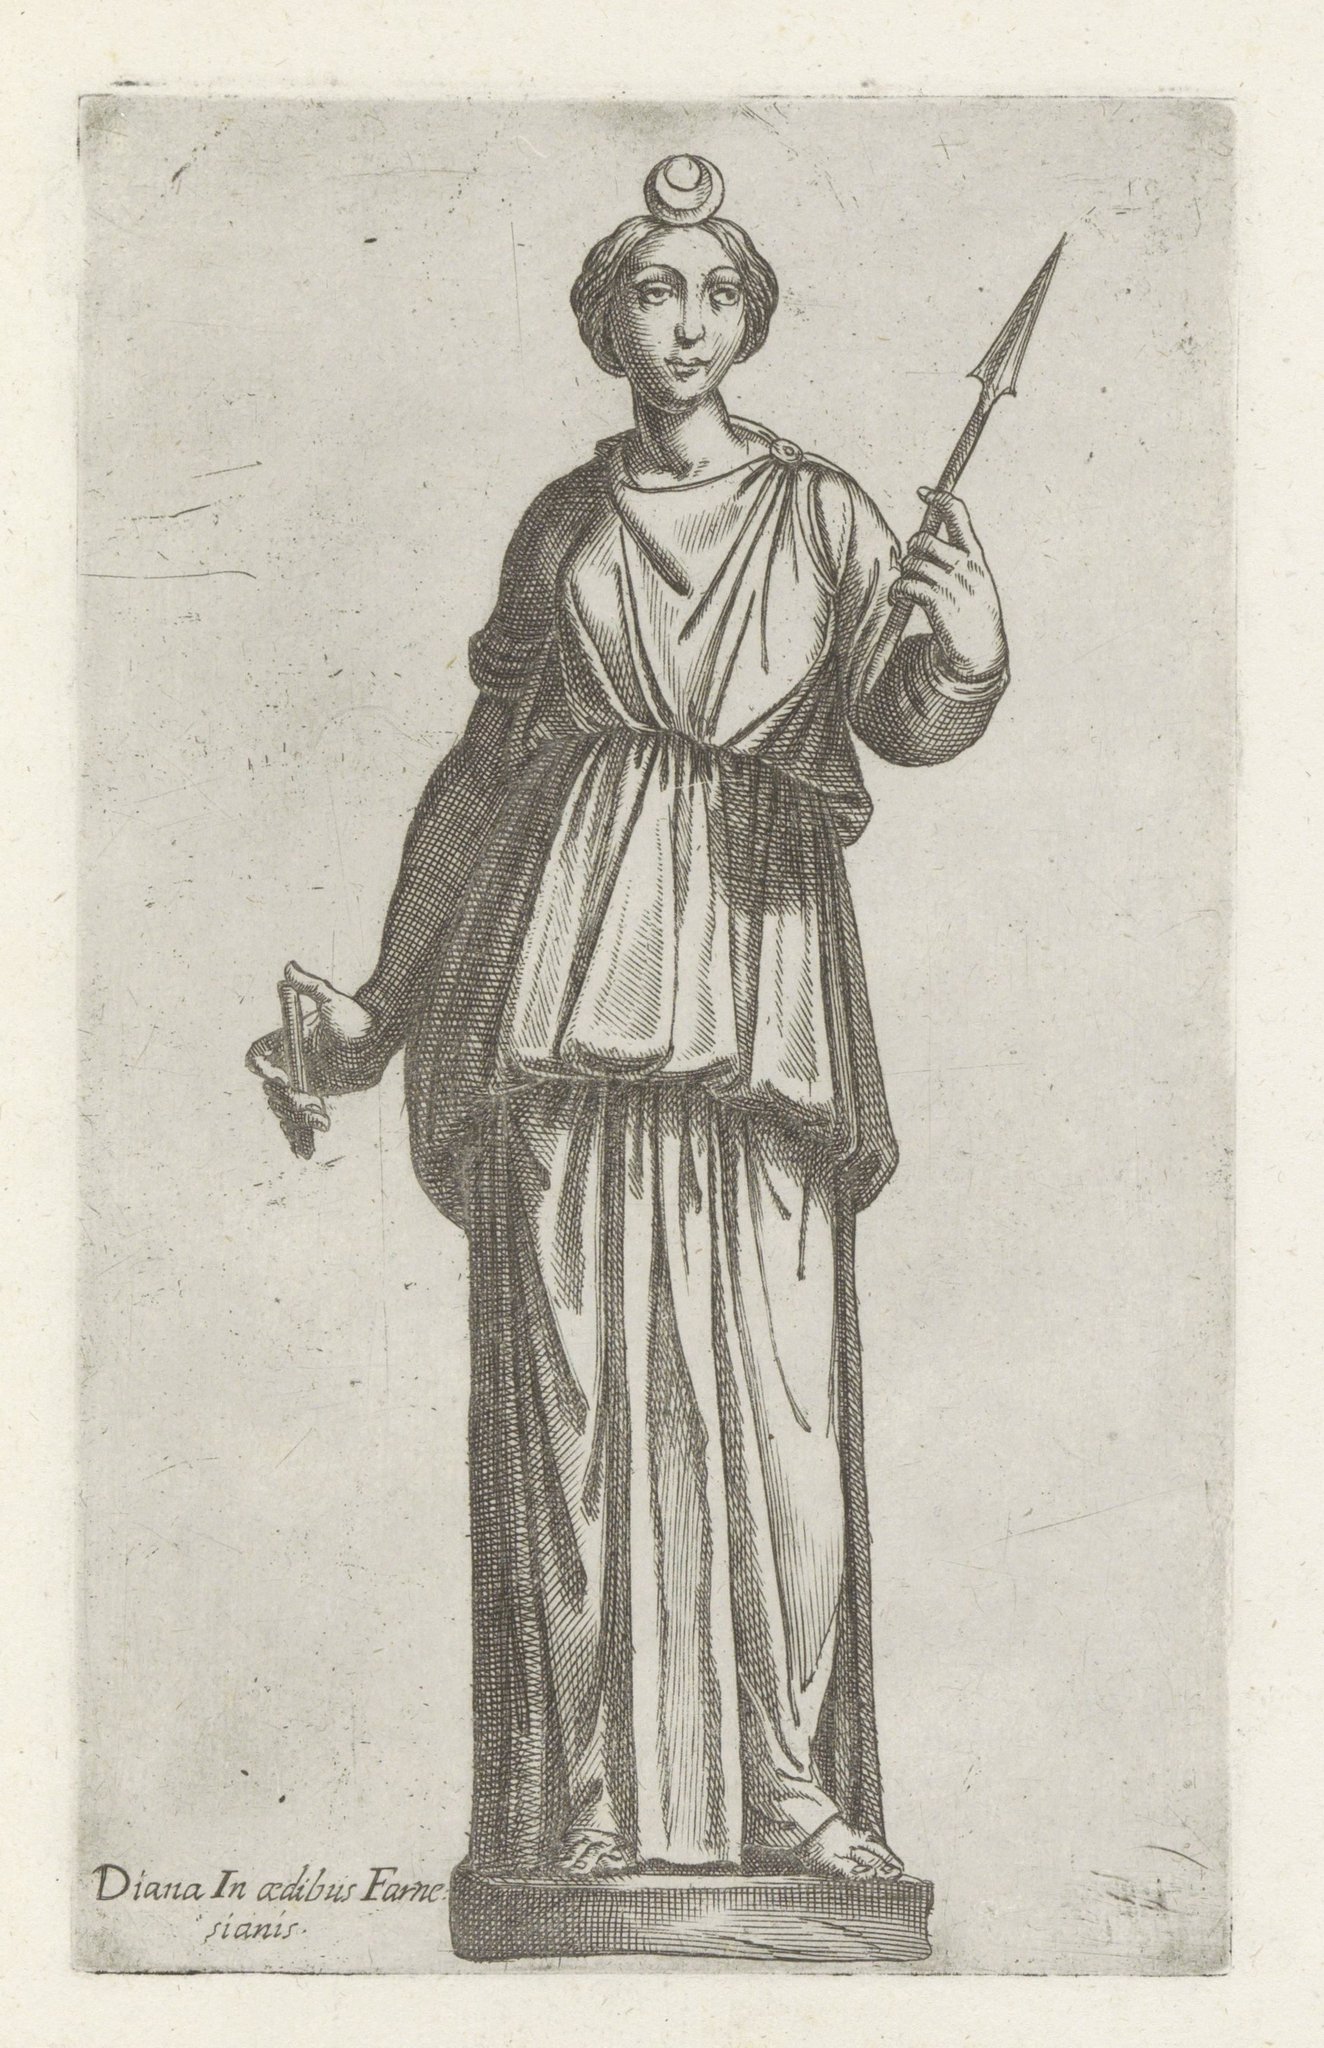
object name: print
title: Antiquarum statuarum urbis Romae quae in publicis locis visuntur icones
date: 1584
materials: paper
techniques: engraving, intaglio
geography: rome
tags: attributes of diana, (story of) diana (artemis), piece of sculpture, reproduction of a piece of sculpture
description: Deze prent maakt deel uit van een set van 79 prenten (+ titelprent) met voorstellingen van antieke sculpturen in Rome.